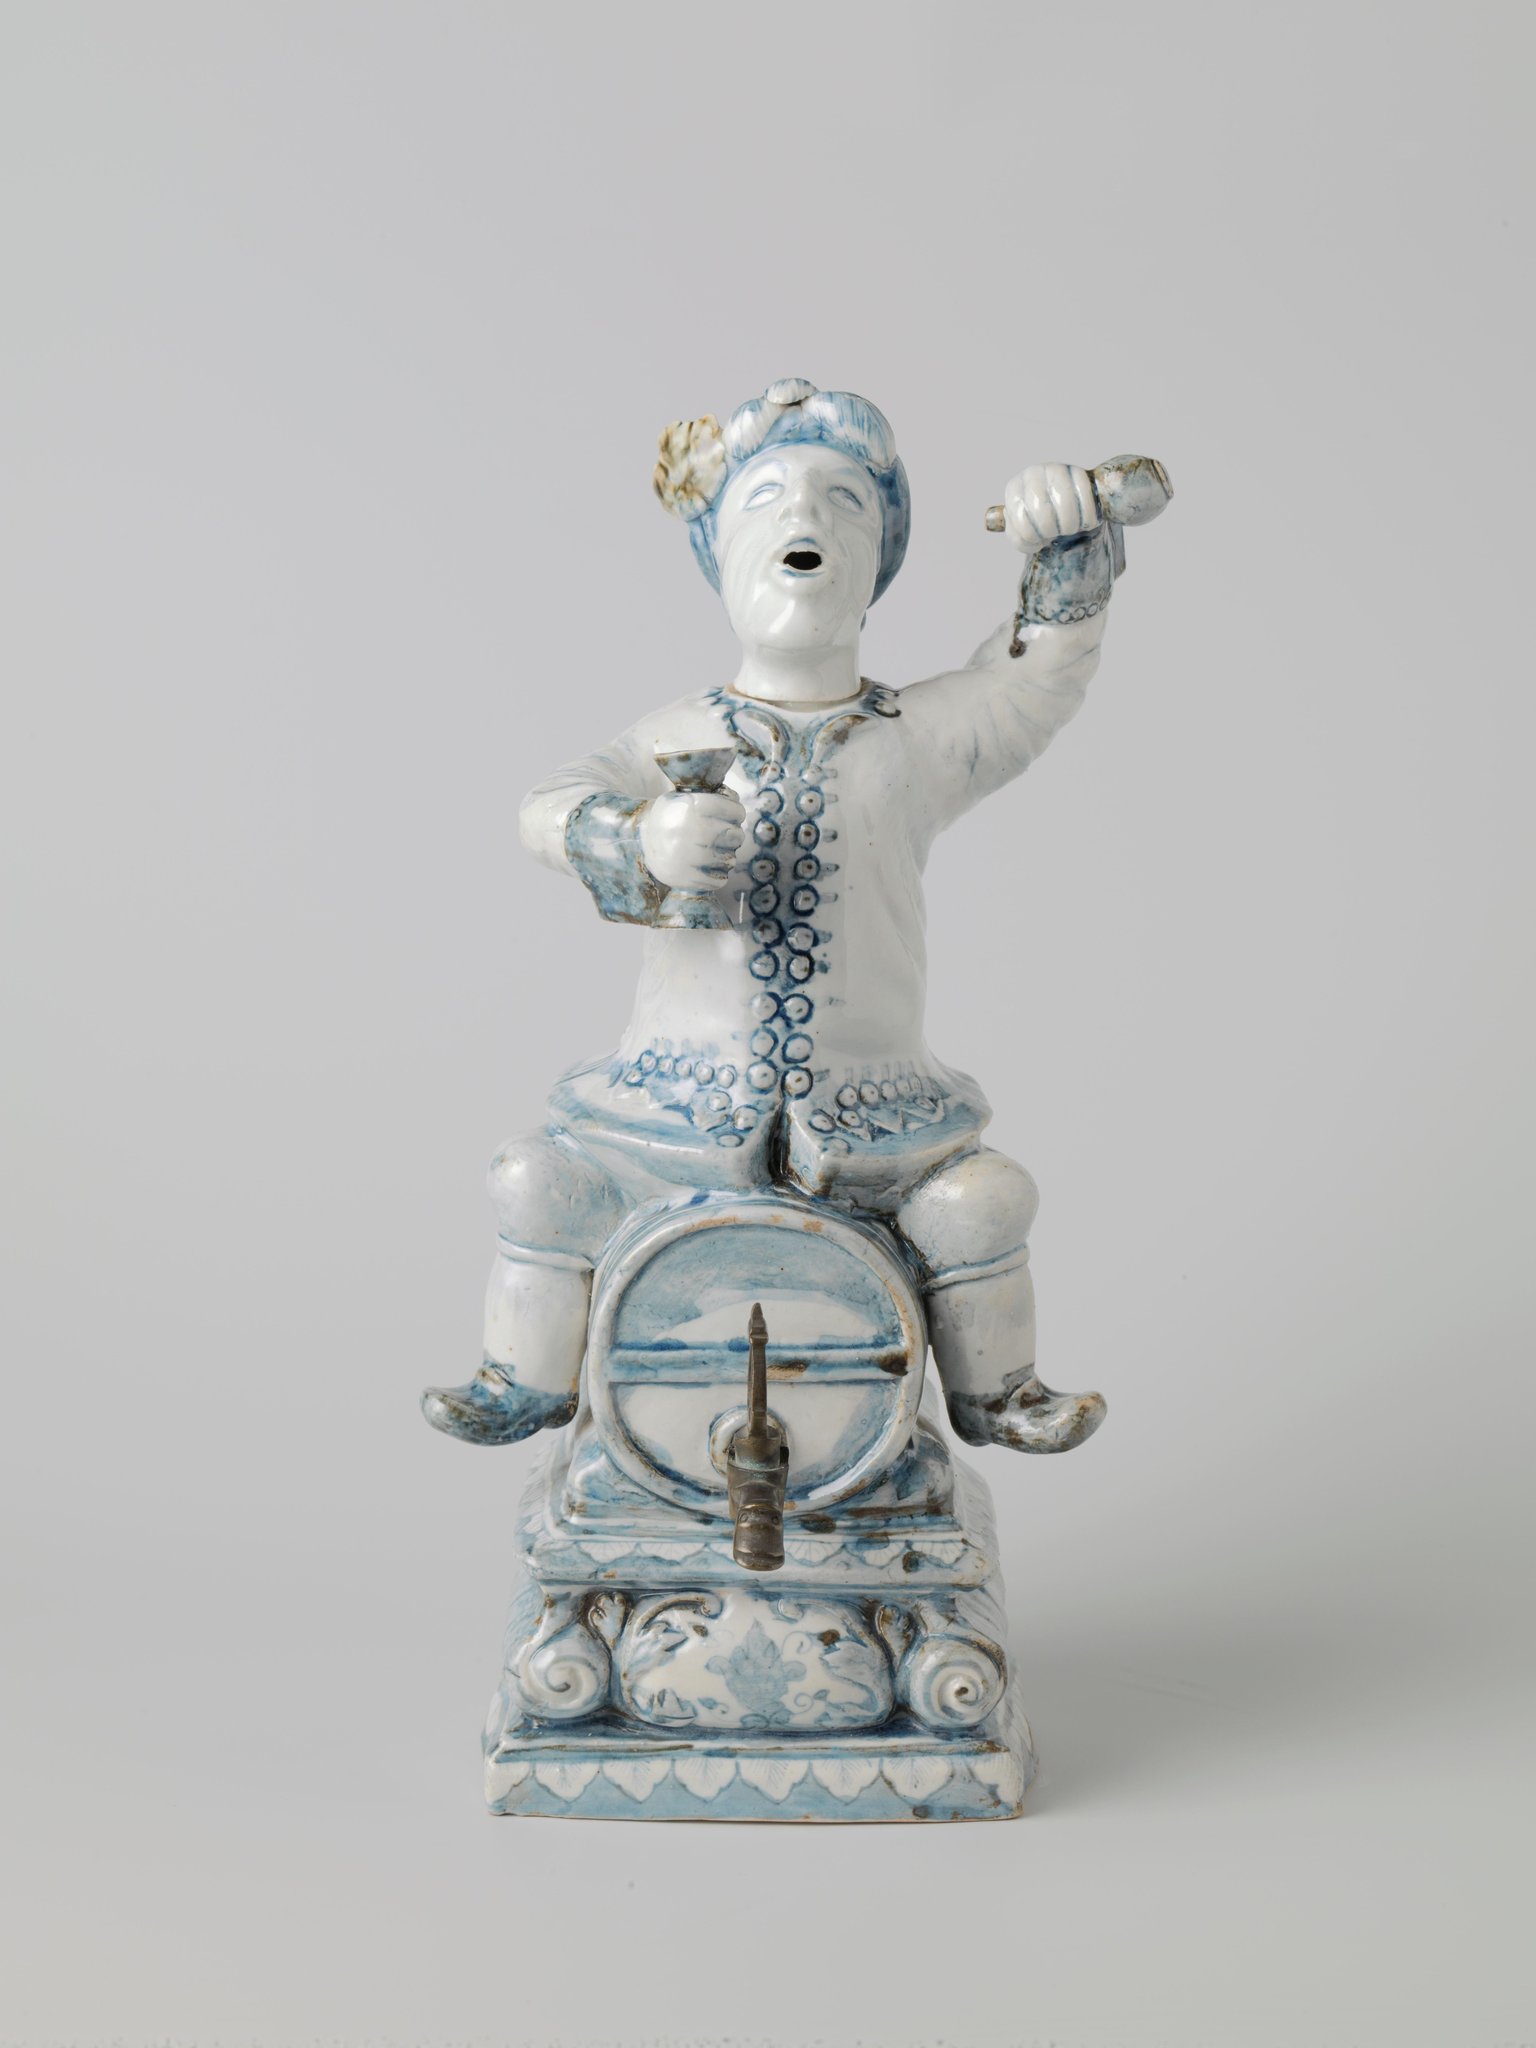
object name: tap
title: Gin Jug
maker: Anonymous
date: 1750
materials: brass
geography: japan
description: Jeneverkruik in de vorm van een man zittende op een ton met glas en fles in de hand, blauw beschilderd. Uit de ton steekt een koperen kraantje. Het hoofd is los en dient als stop.